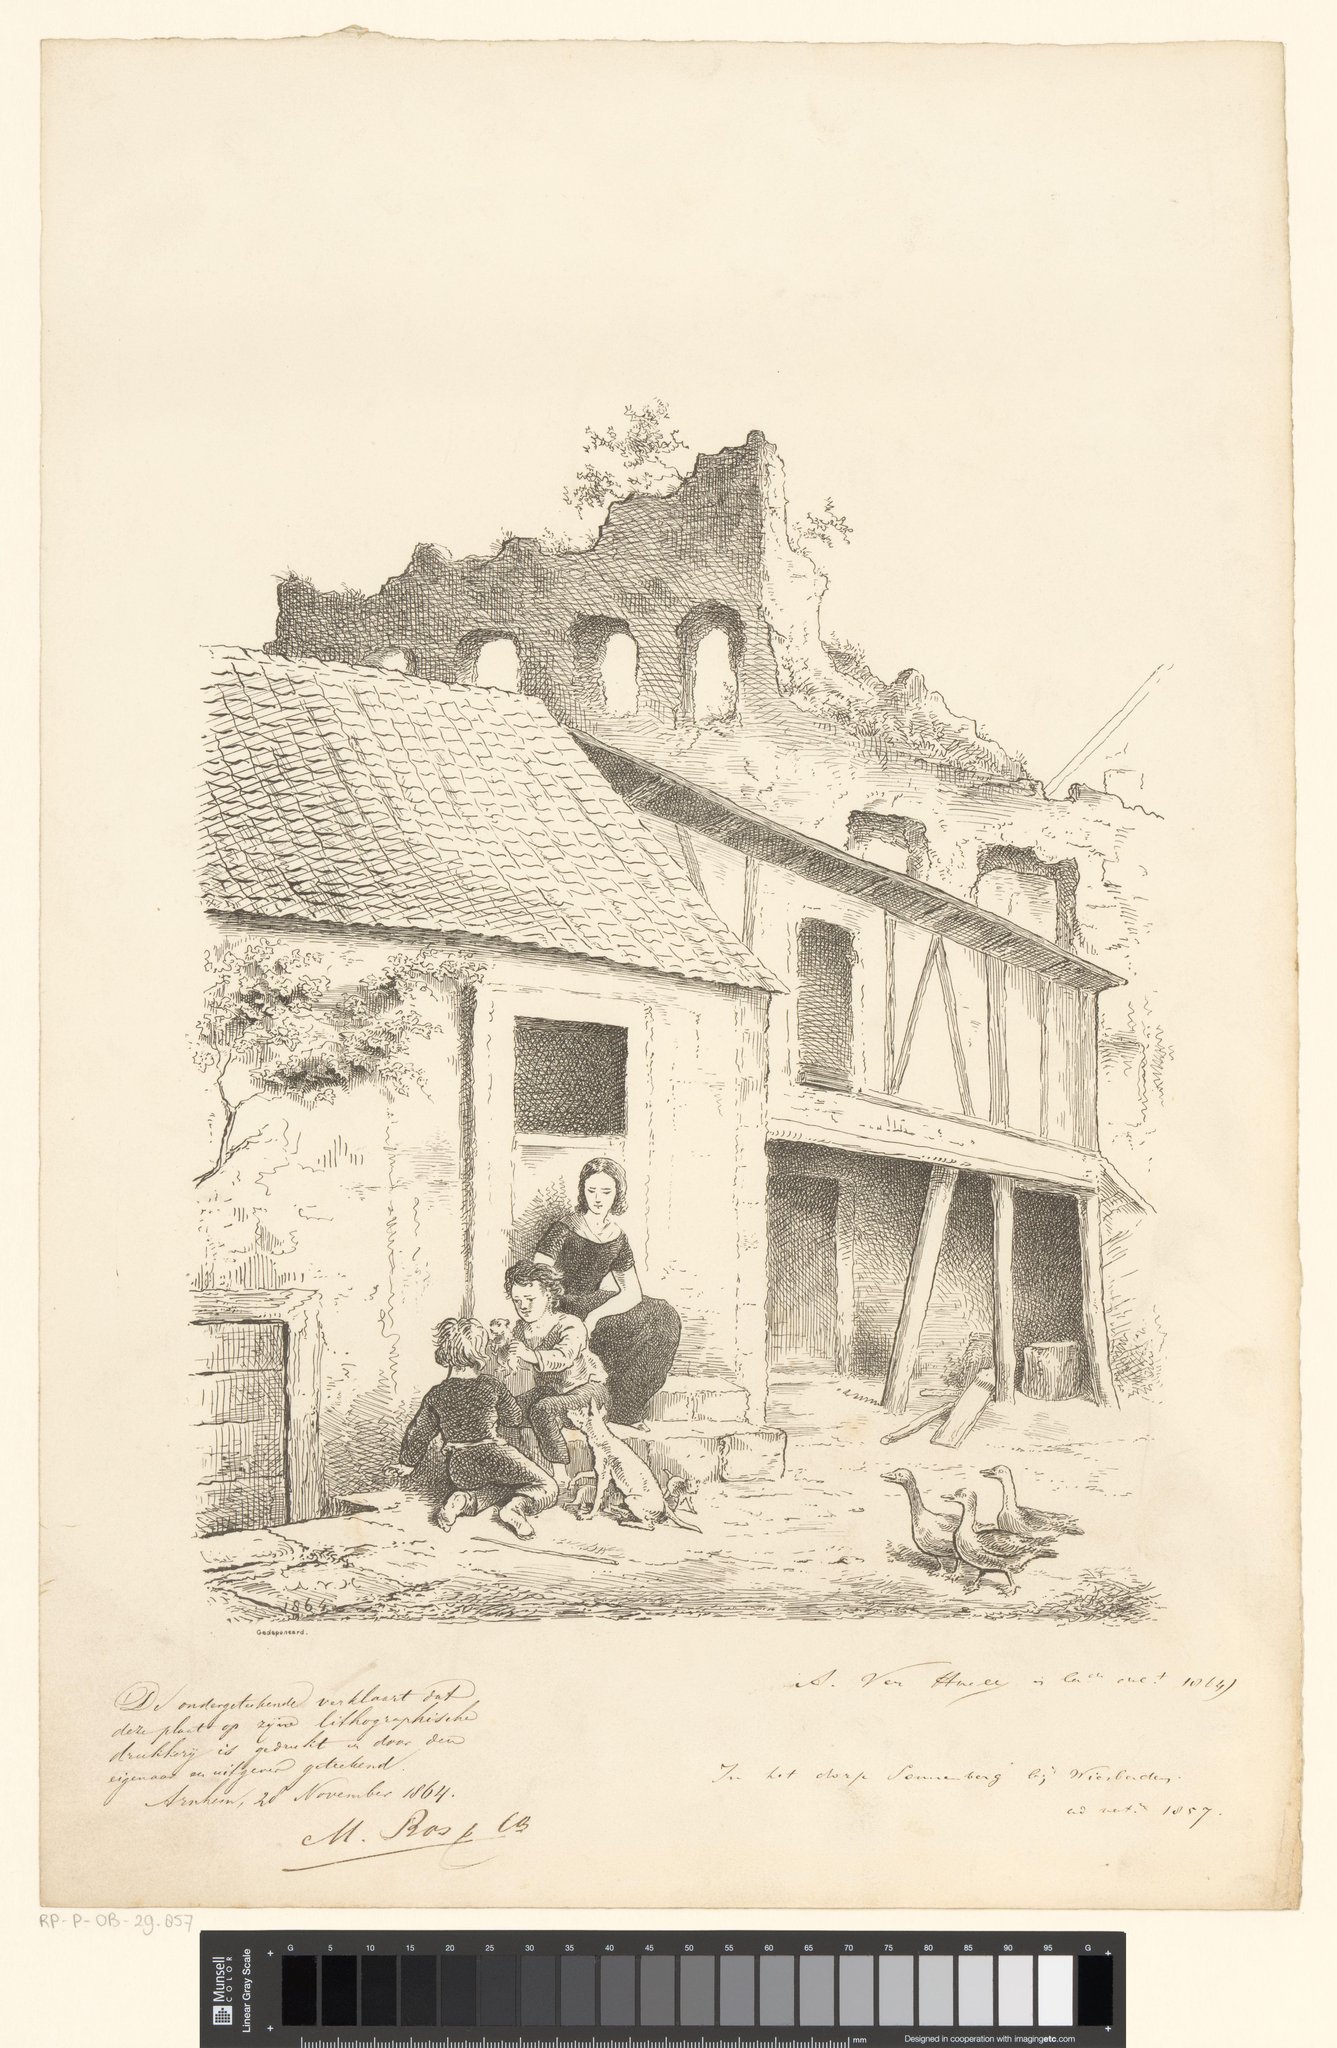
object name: print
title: Uit het verleden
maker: alexander ver huell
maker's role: draughtsman, print maker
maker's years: 1822-1897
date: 1864-1866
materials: paper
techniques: lithograph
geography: arnhem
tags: mother and child(ren), woman and child(ren) (family group), dog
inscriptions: collector's mark: Lugt 2228, : ‘Gedeponeerd.’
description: Een vrouw zit met haar twee kinderen op de stoep voor haar huis in het dorp Sonnenberg bij Wiesbaden. De kinderen spelen met de puppy's van de hond die naast hen zit. In de achtergrond een ruïne.